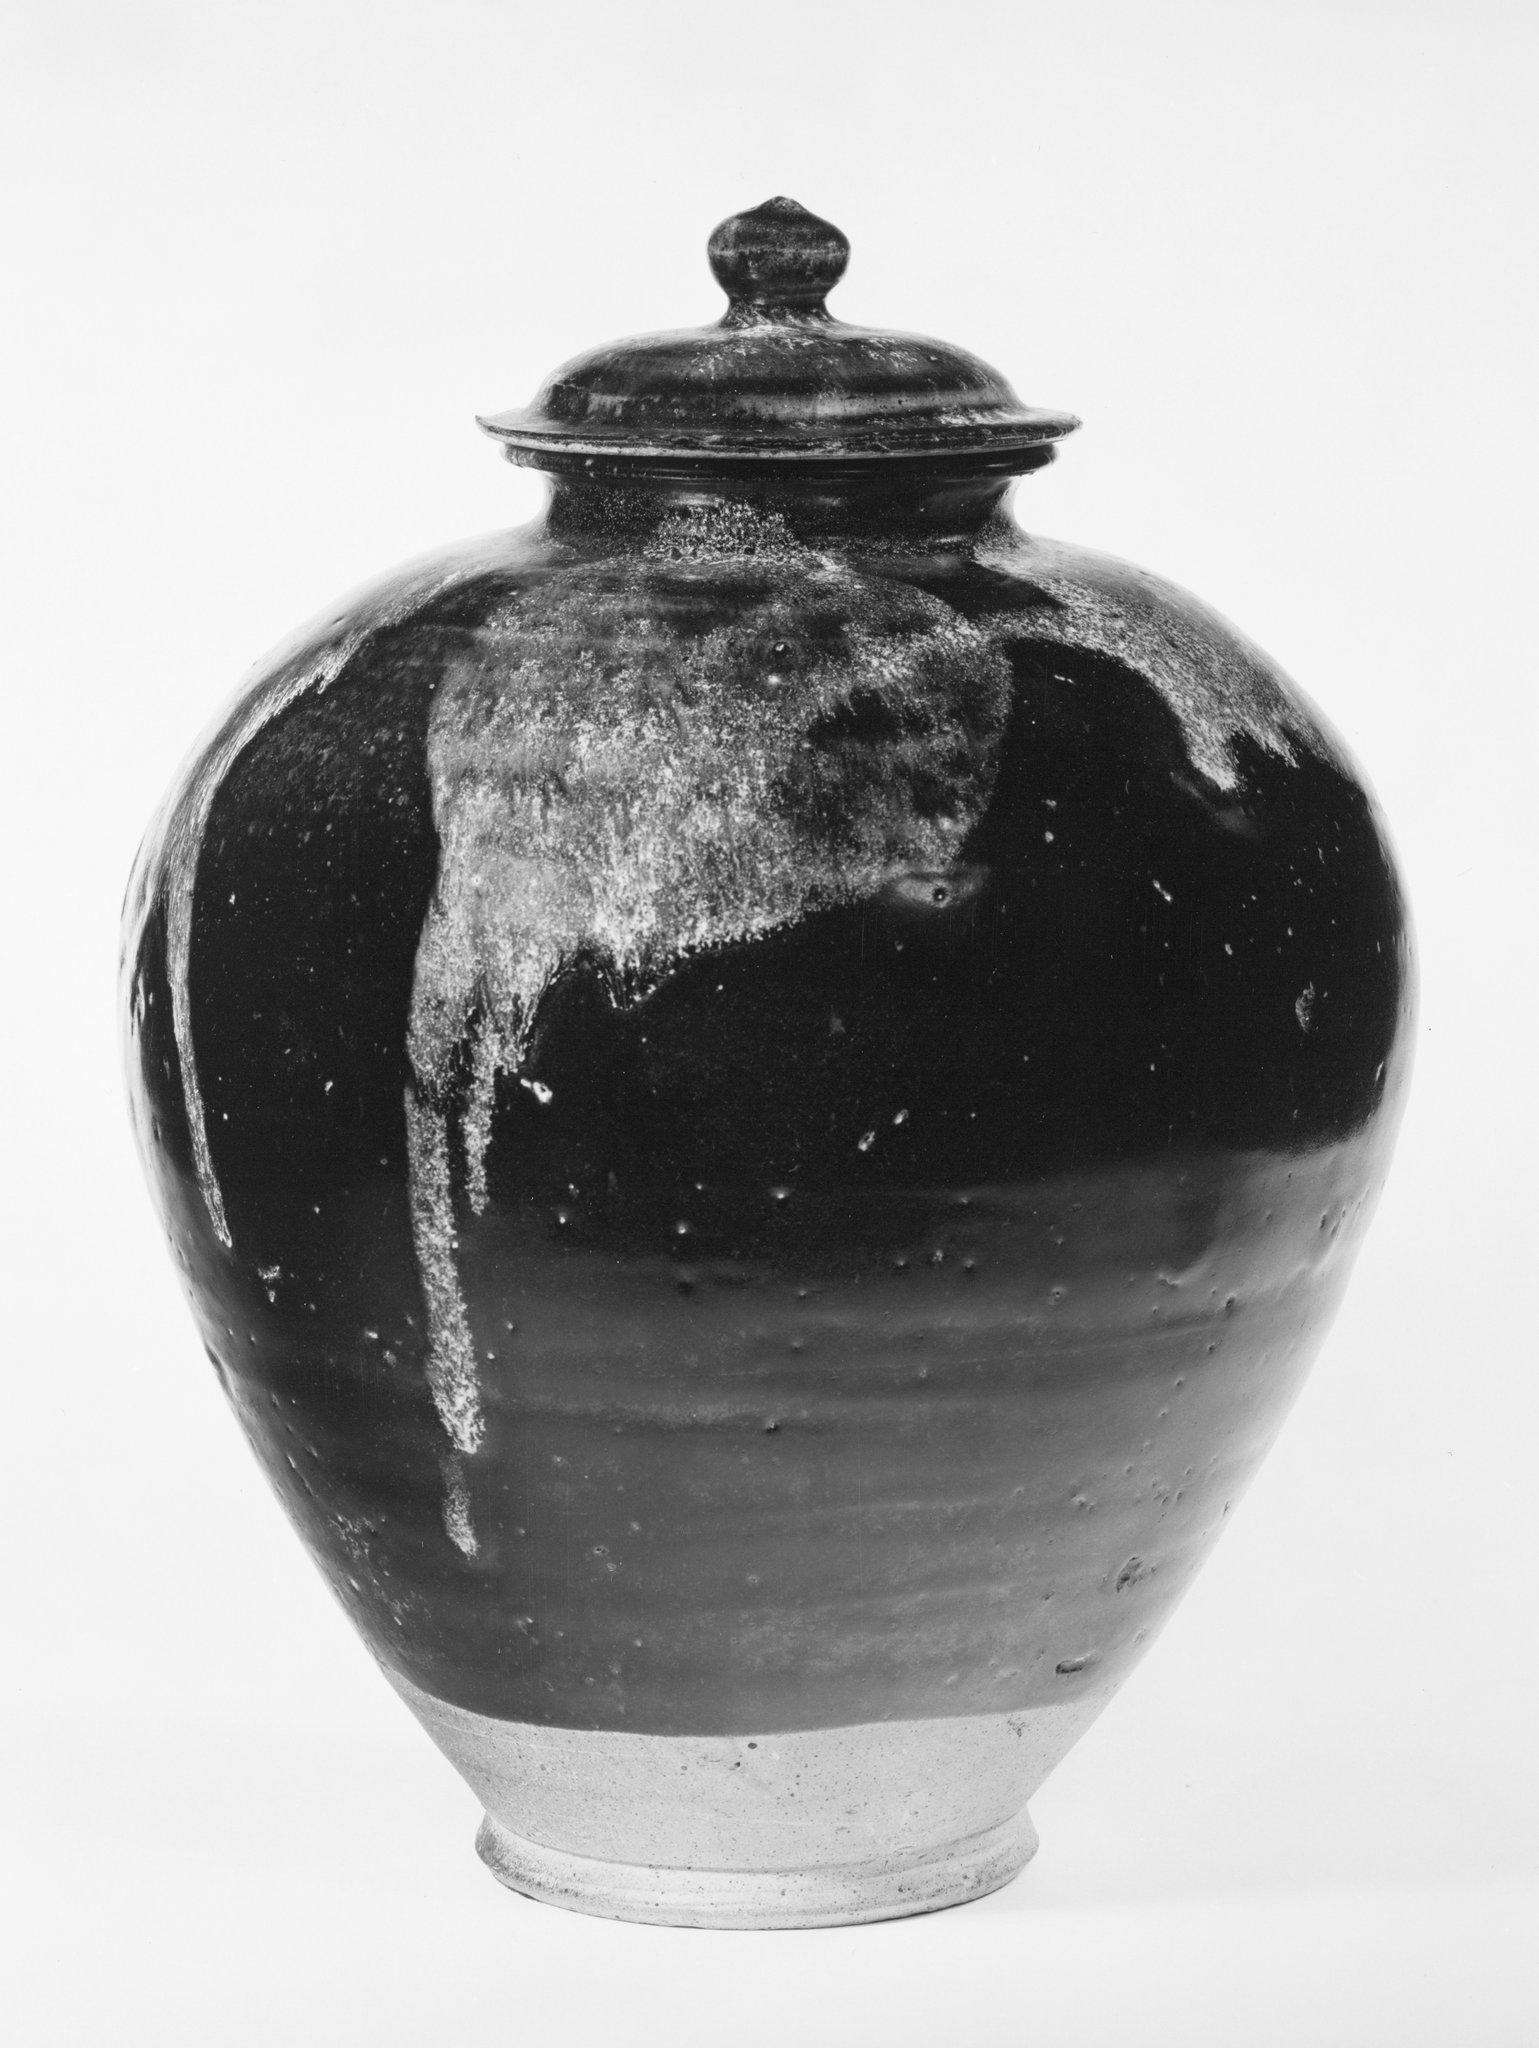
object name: jar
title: Covered jar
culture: chinese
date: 701-800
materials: earthenware, glaze